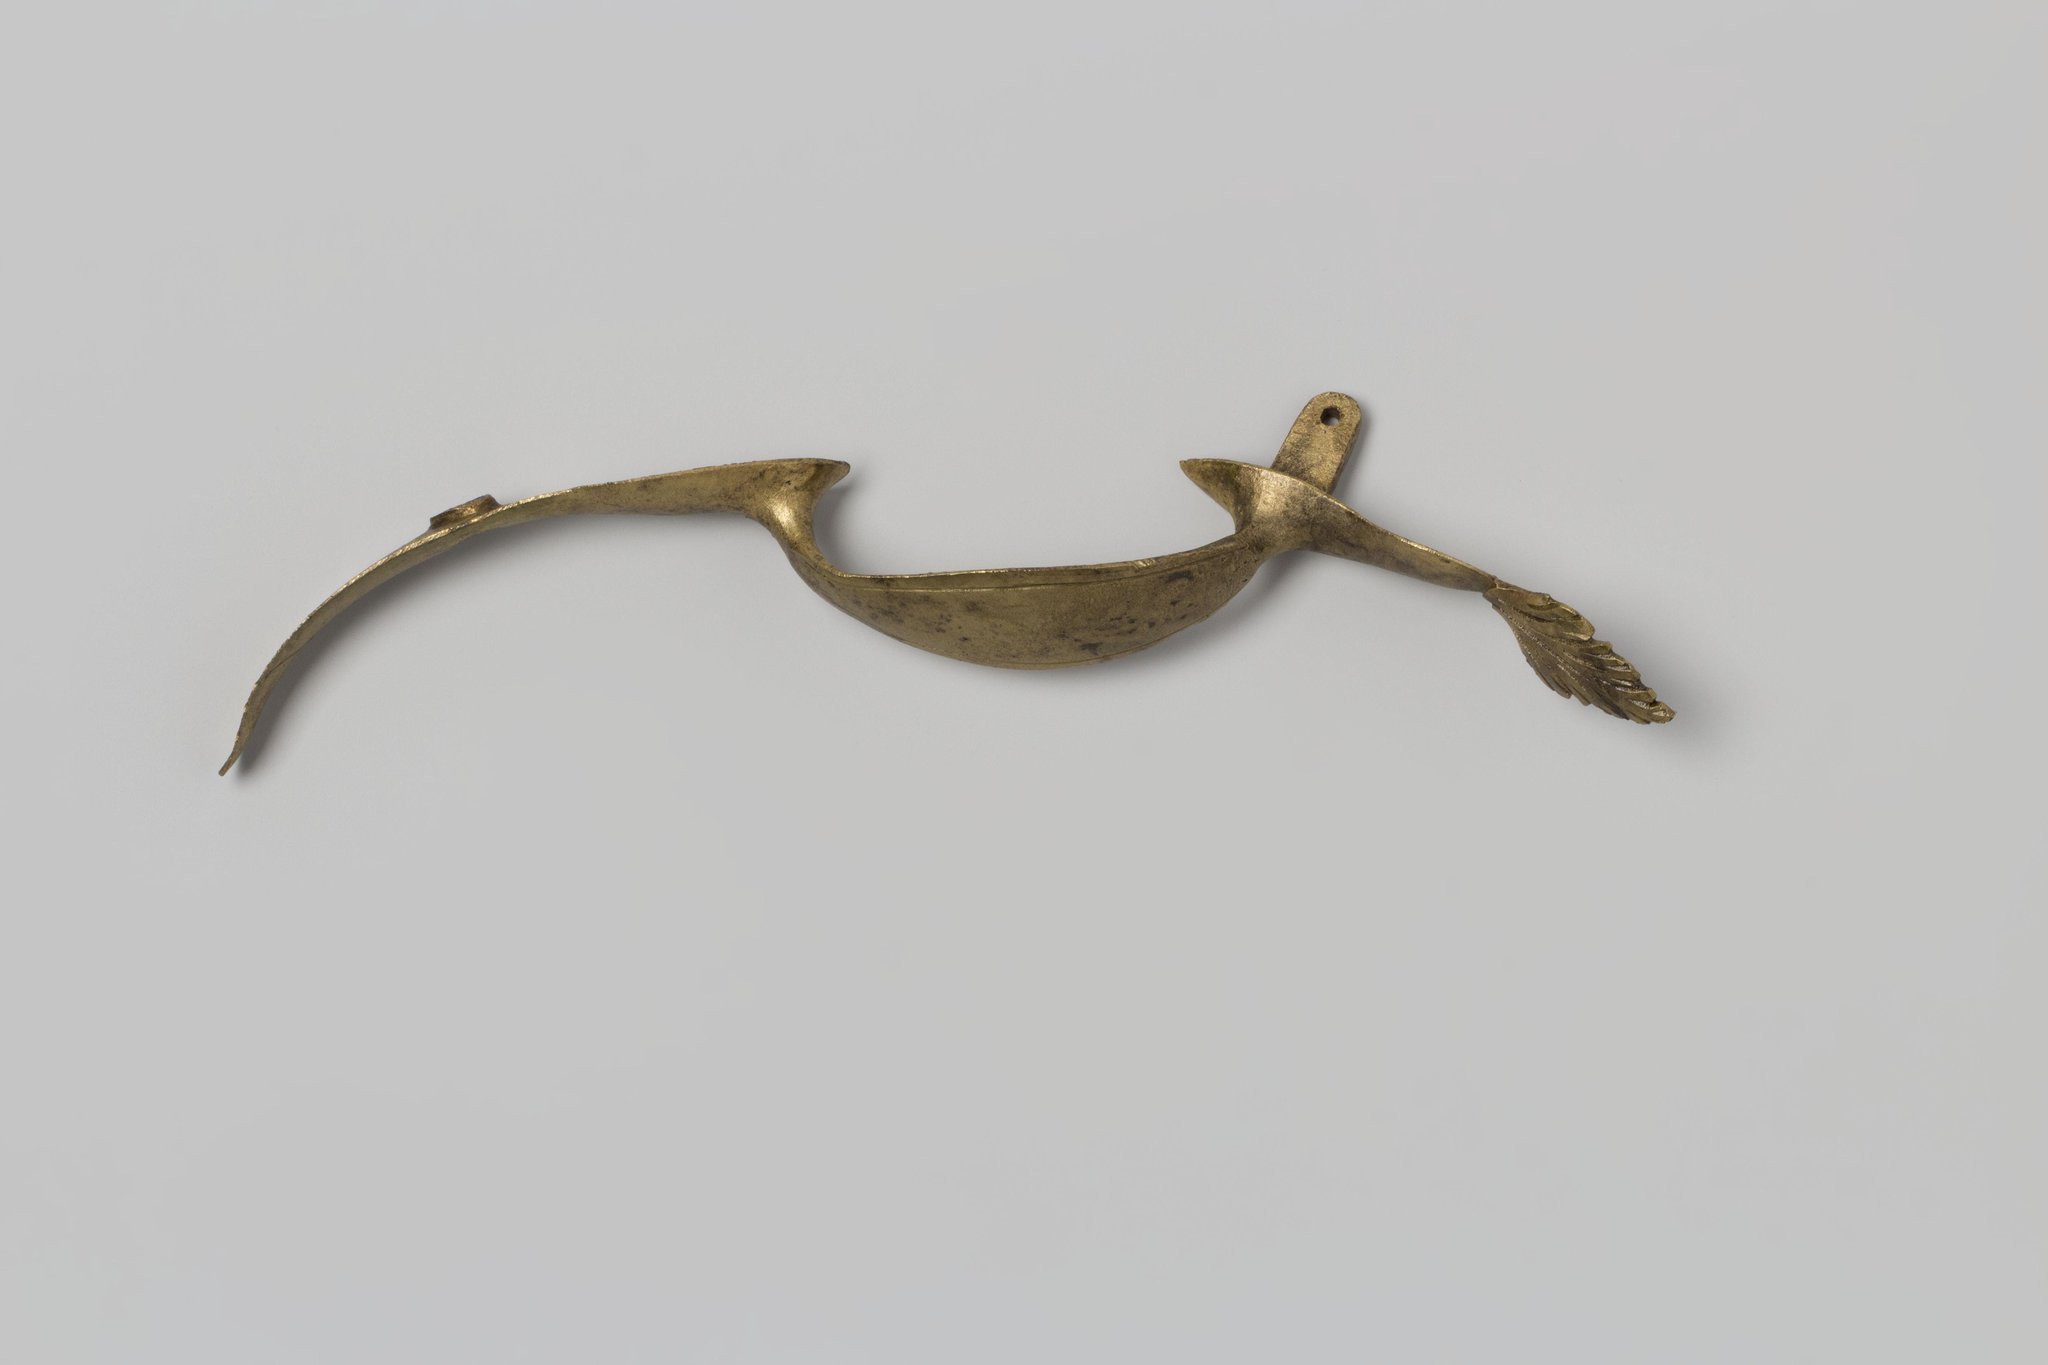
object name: pistol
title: Trekkerbeugel van een pistool uit het wrak van de Oost-Indiëvaarder Hollandia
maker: Anonymous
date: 1700-1743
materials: copper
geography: netherlands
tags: verenigde oostindische compagnie, hollandia (schip), annet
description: Pistol, trigger guard; id. NG 1978-54H1651.